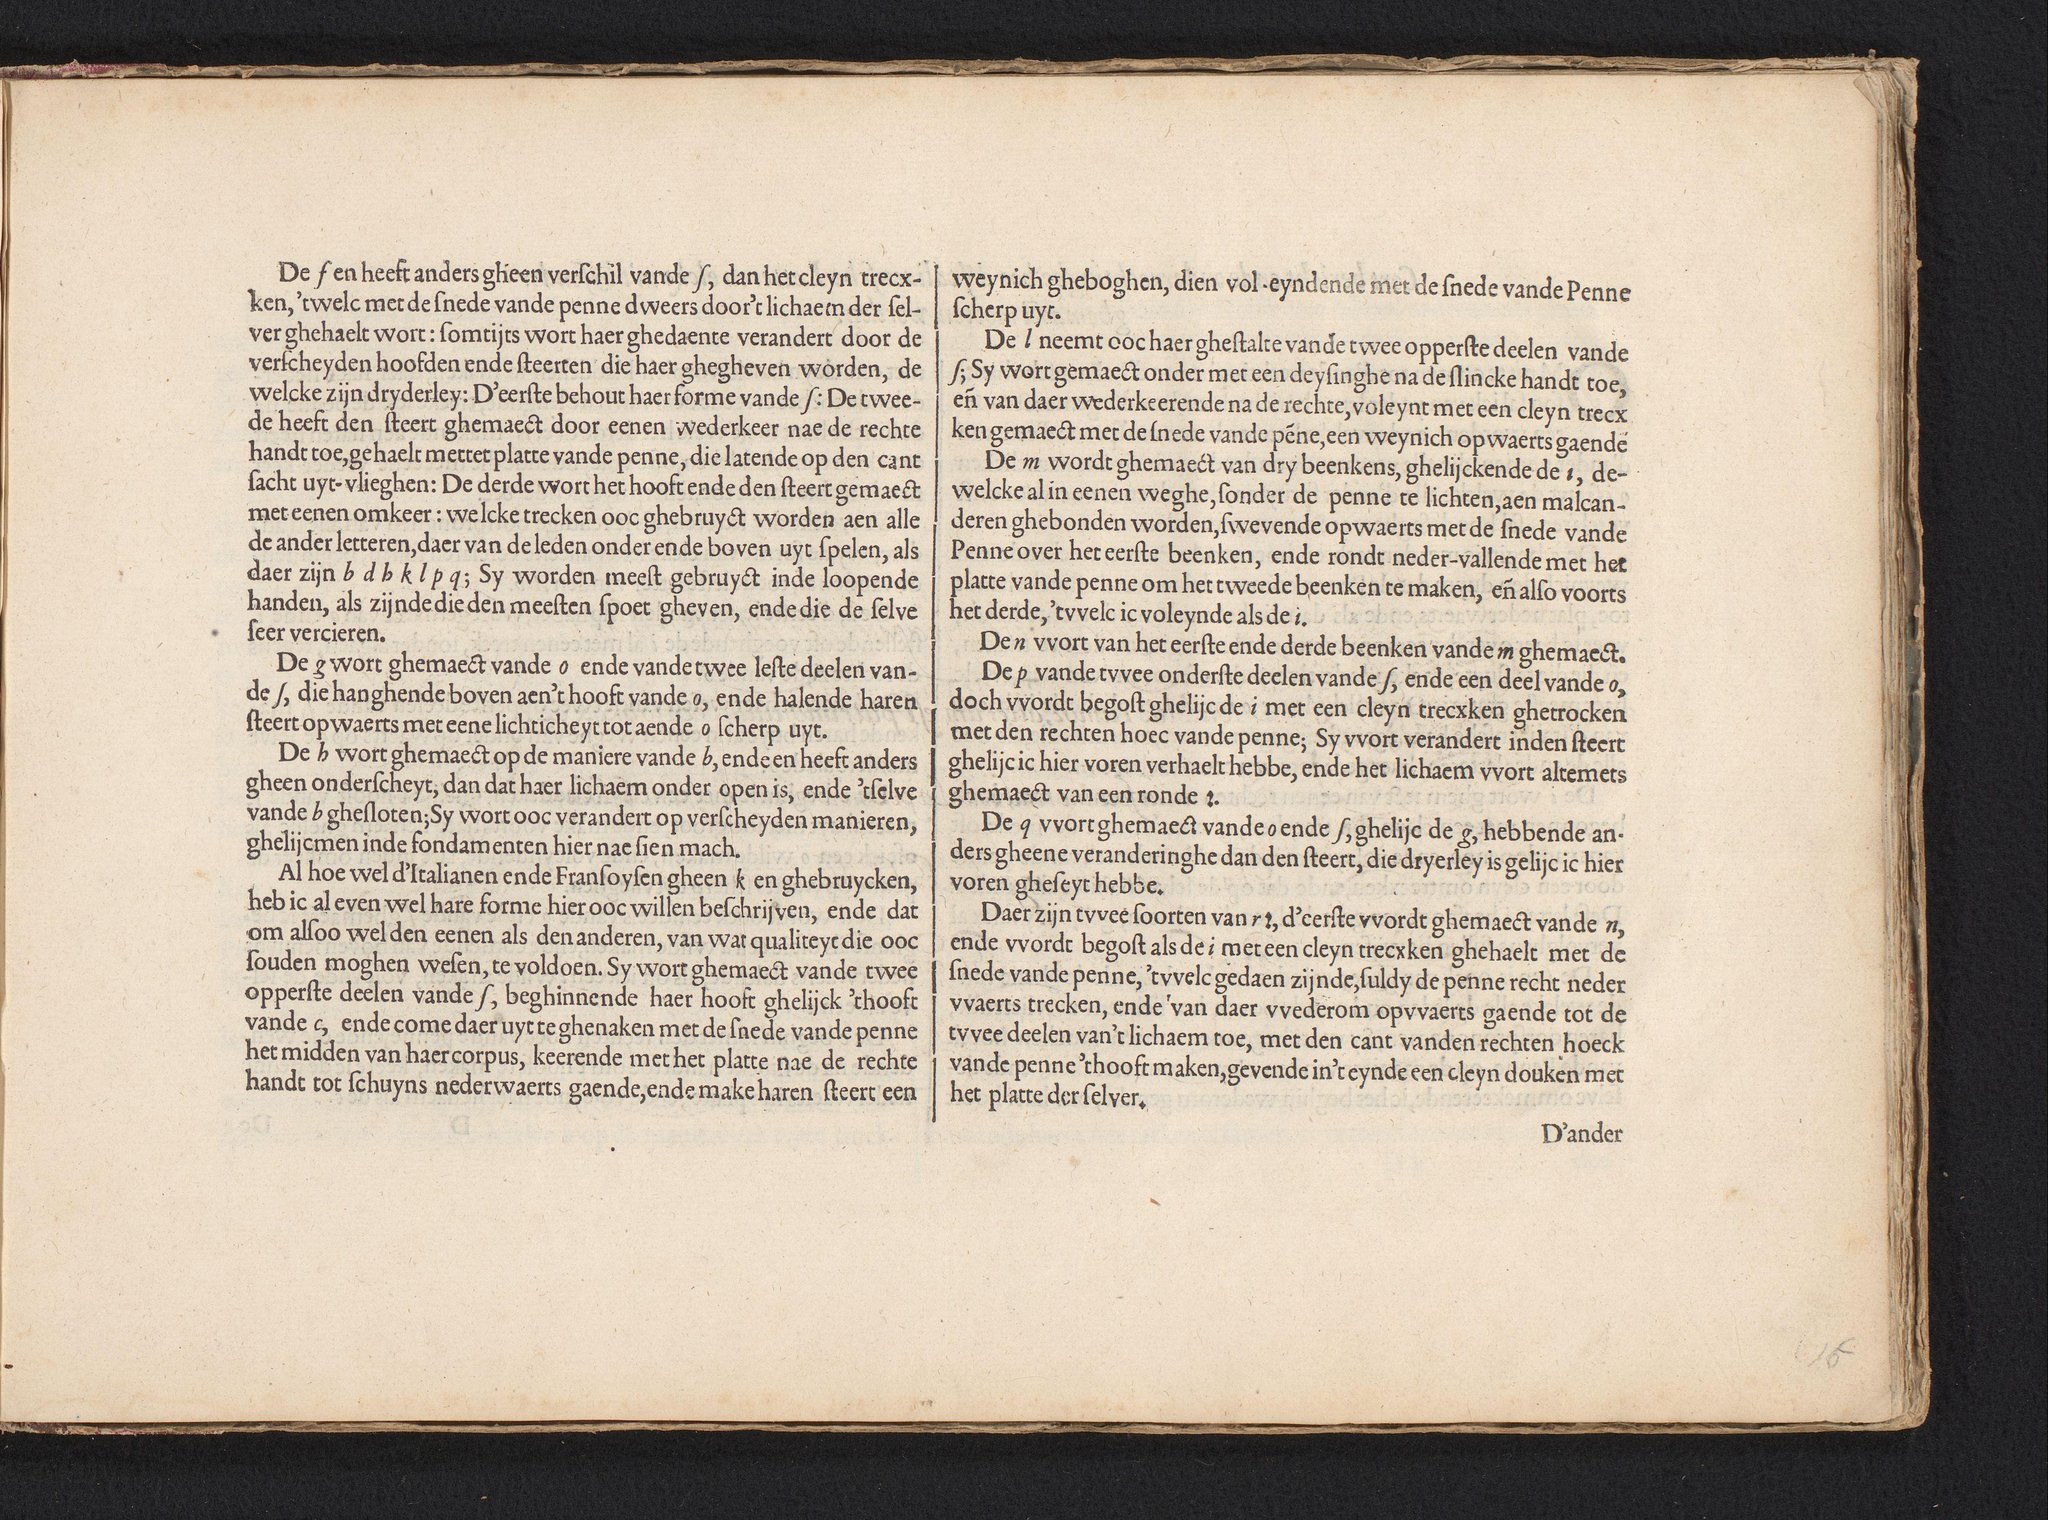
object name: album leaf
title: Spieghel der schrijfkonste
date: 1608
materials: paper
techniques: letterpress printing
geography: amsterdam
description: Folio D1v met het vervolg van de instructie hoe de Italiaanse letter geschreven moet worden. Het blad maakt deel uit van een album.